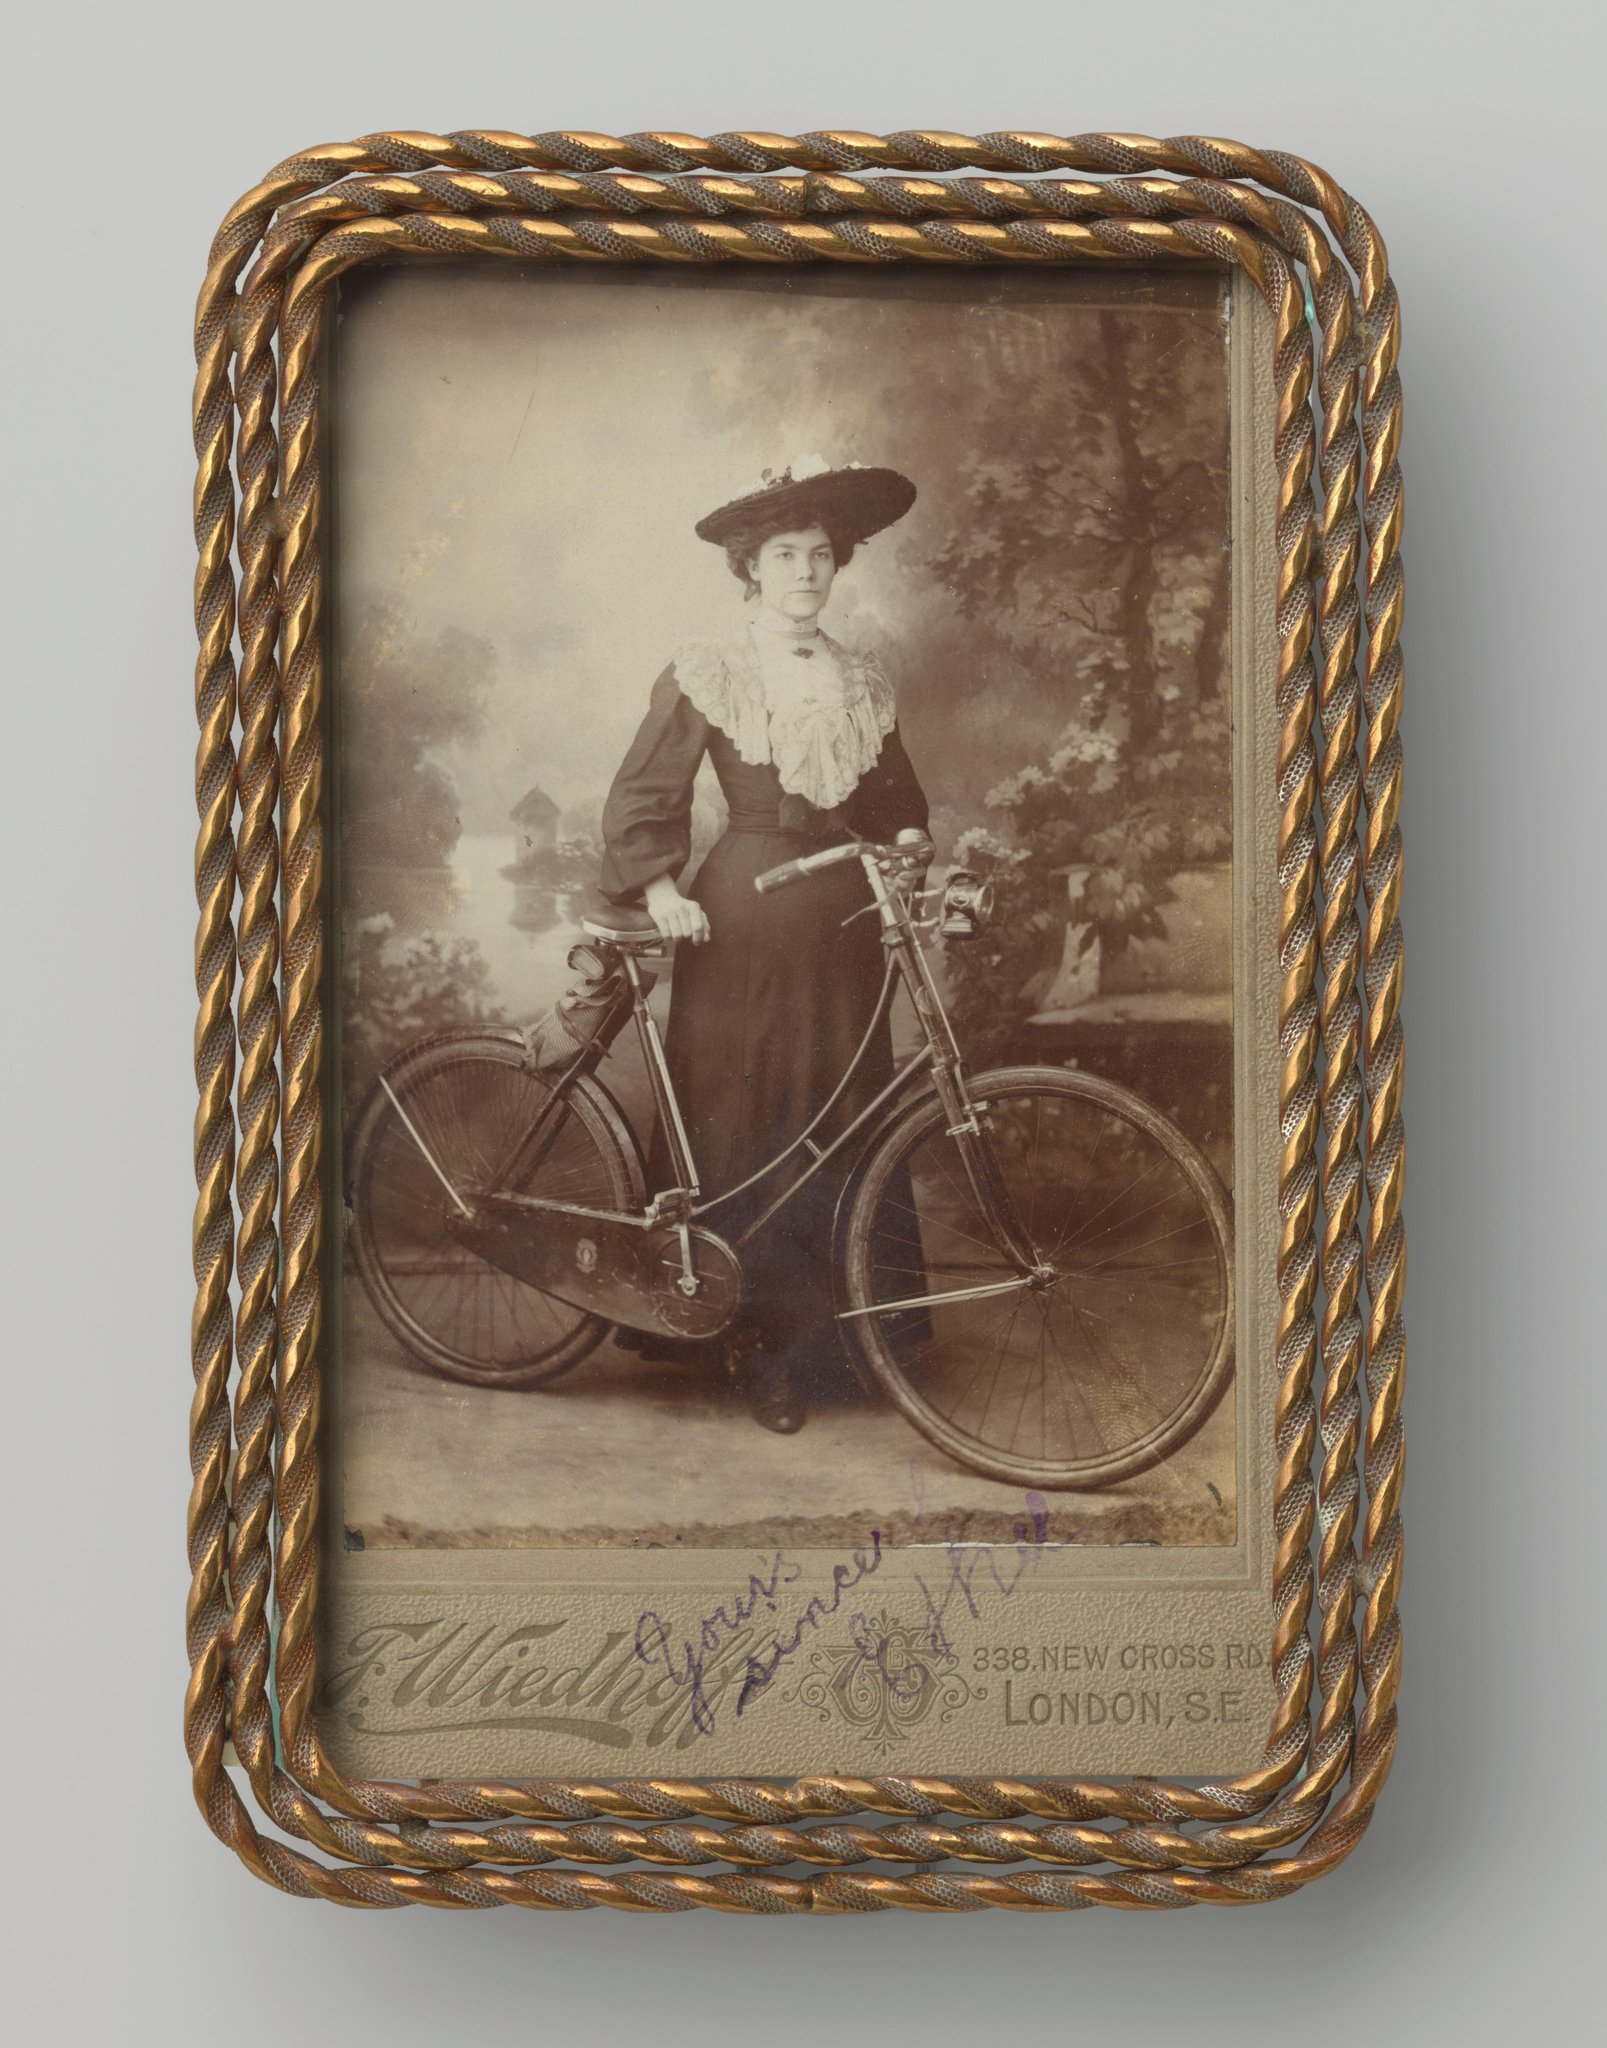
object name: frame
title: Portret van een onbekende vrouw met een fiets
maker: frederick wiedhofft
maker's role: fotograaf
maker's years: 1853-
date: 1900-1909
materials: paper, cardboard, glass, metal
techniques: gelatin silver print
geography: london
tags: adult woman, bicycle, anonymous historical person portrayed - bb - woman, london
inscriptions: inscription: ‘Day & electric light studios/ F. Wiedhofft/ Art Photographer/ (...) London./ Established 1879.’, inscription: ‘Yours/ sincerely/ Ethel’